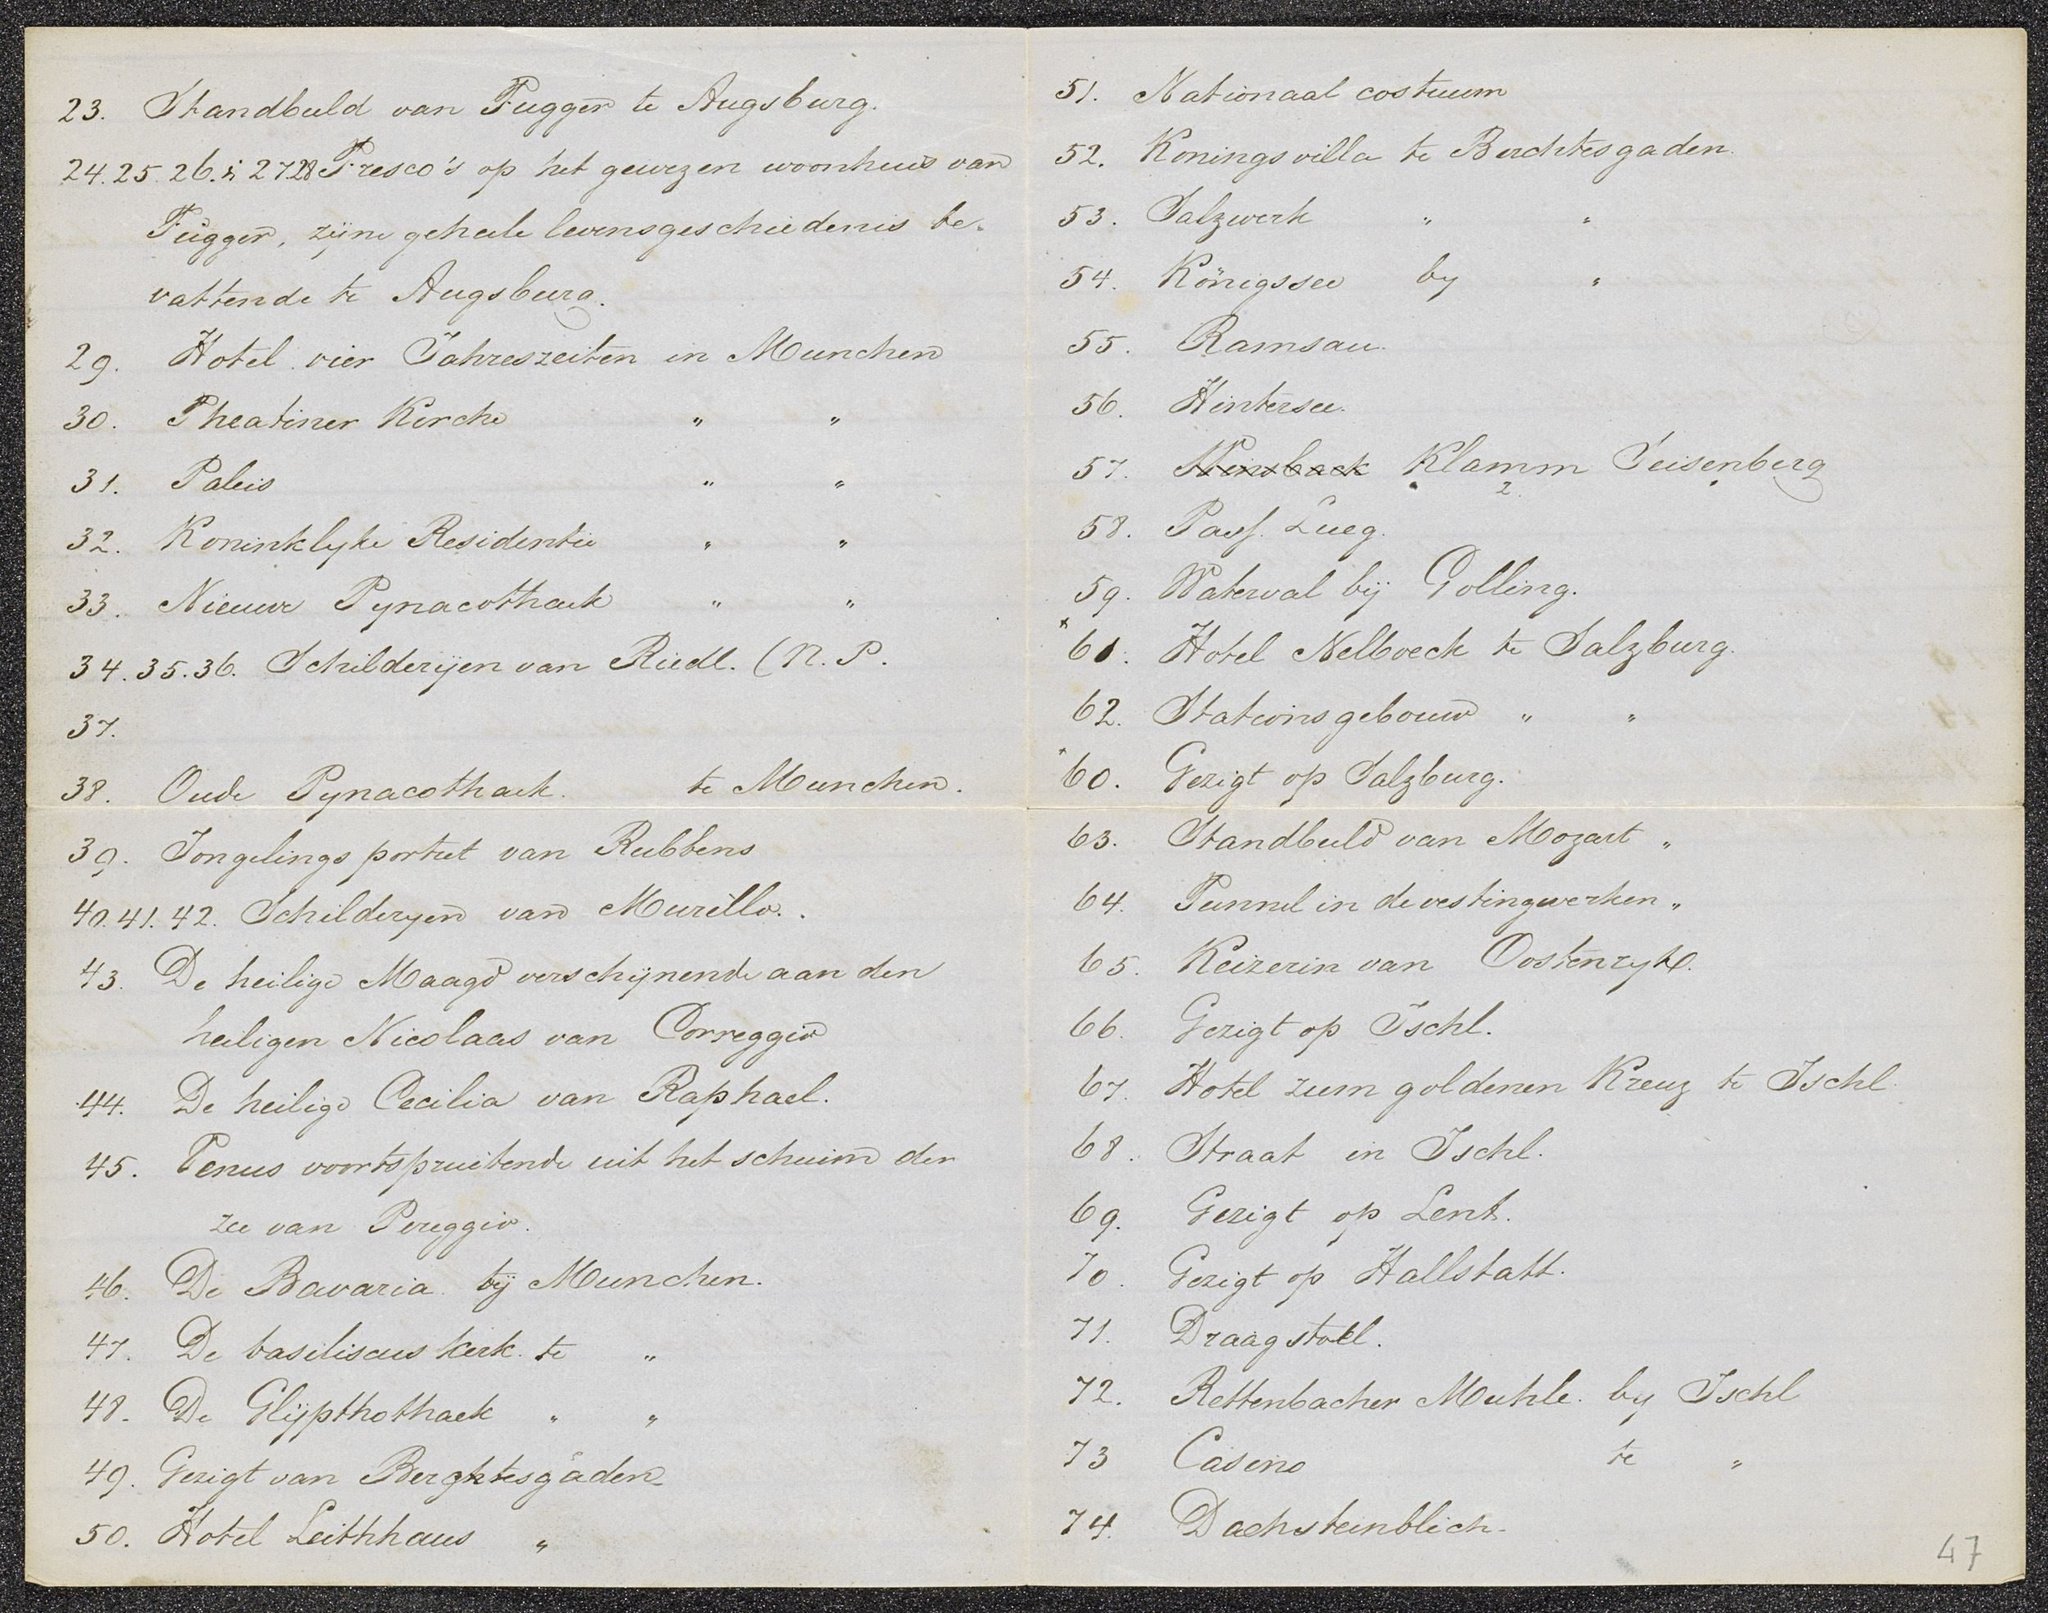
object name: paper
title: Beschrijvingen der plaatjes zich bevindende in het Album, & betreffende de reis van 1865.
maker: Anonymous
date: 1865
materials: ink, paper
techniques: writing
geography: netherlands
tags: handwriting, written text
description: Handgeschreven en genummerde lijst met beschrijvingen van foto's en prenten in het album. Onderdeel van Fotoalbum van een reis door Zwitserland, Oostenrijk en Duitsland door de Nederlandse familie Derkinderen.